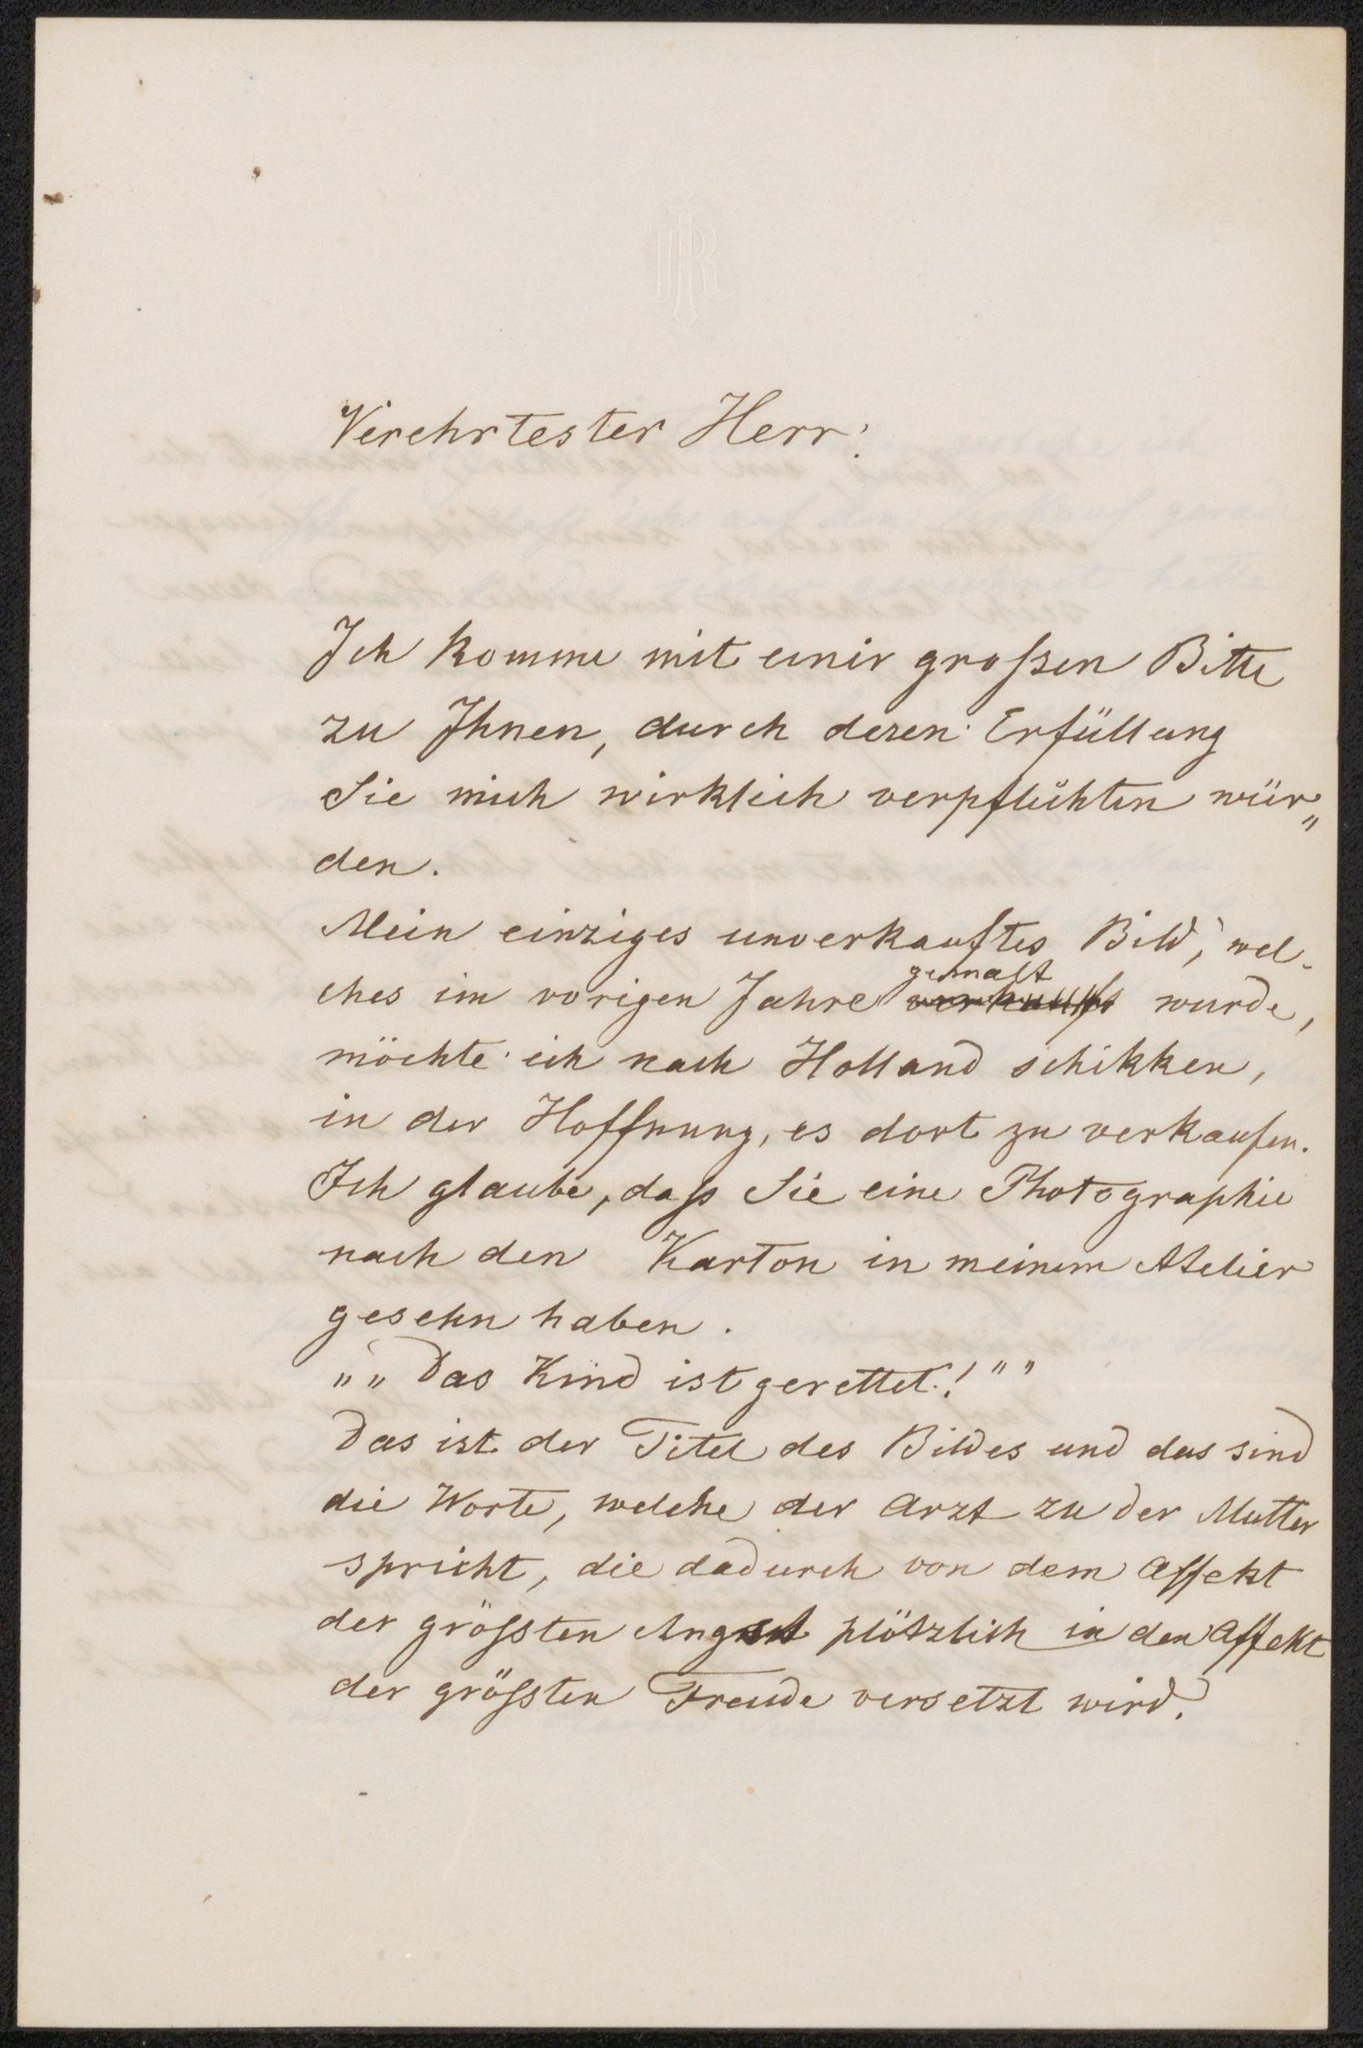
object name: letter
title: Brief aan Ary Johannes Lamme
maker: rudolf jordan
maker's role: draughtsman, print maker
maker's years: 1810-1887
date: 1862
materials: ink, paper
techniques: pen, writing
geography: dusseldorf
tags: ary johannes lamme, art trade, art shop, painting (including book-illumination, miniature-painting), money, netherlands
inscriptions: monogram: ‘RJ’, collector's mark: Lugt 2228